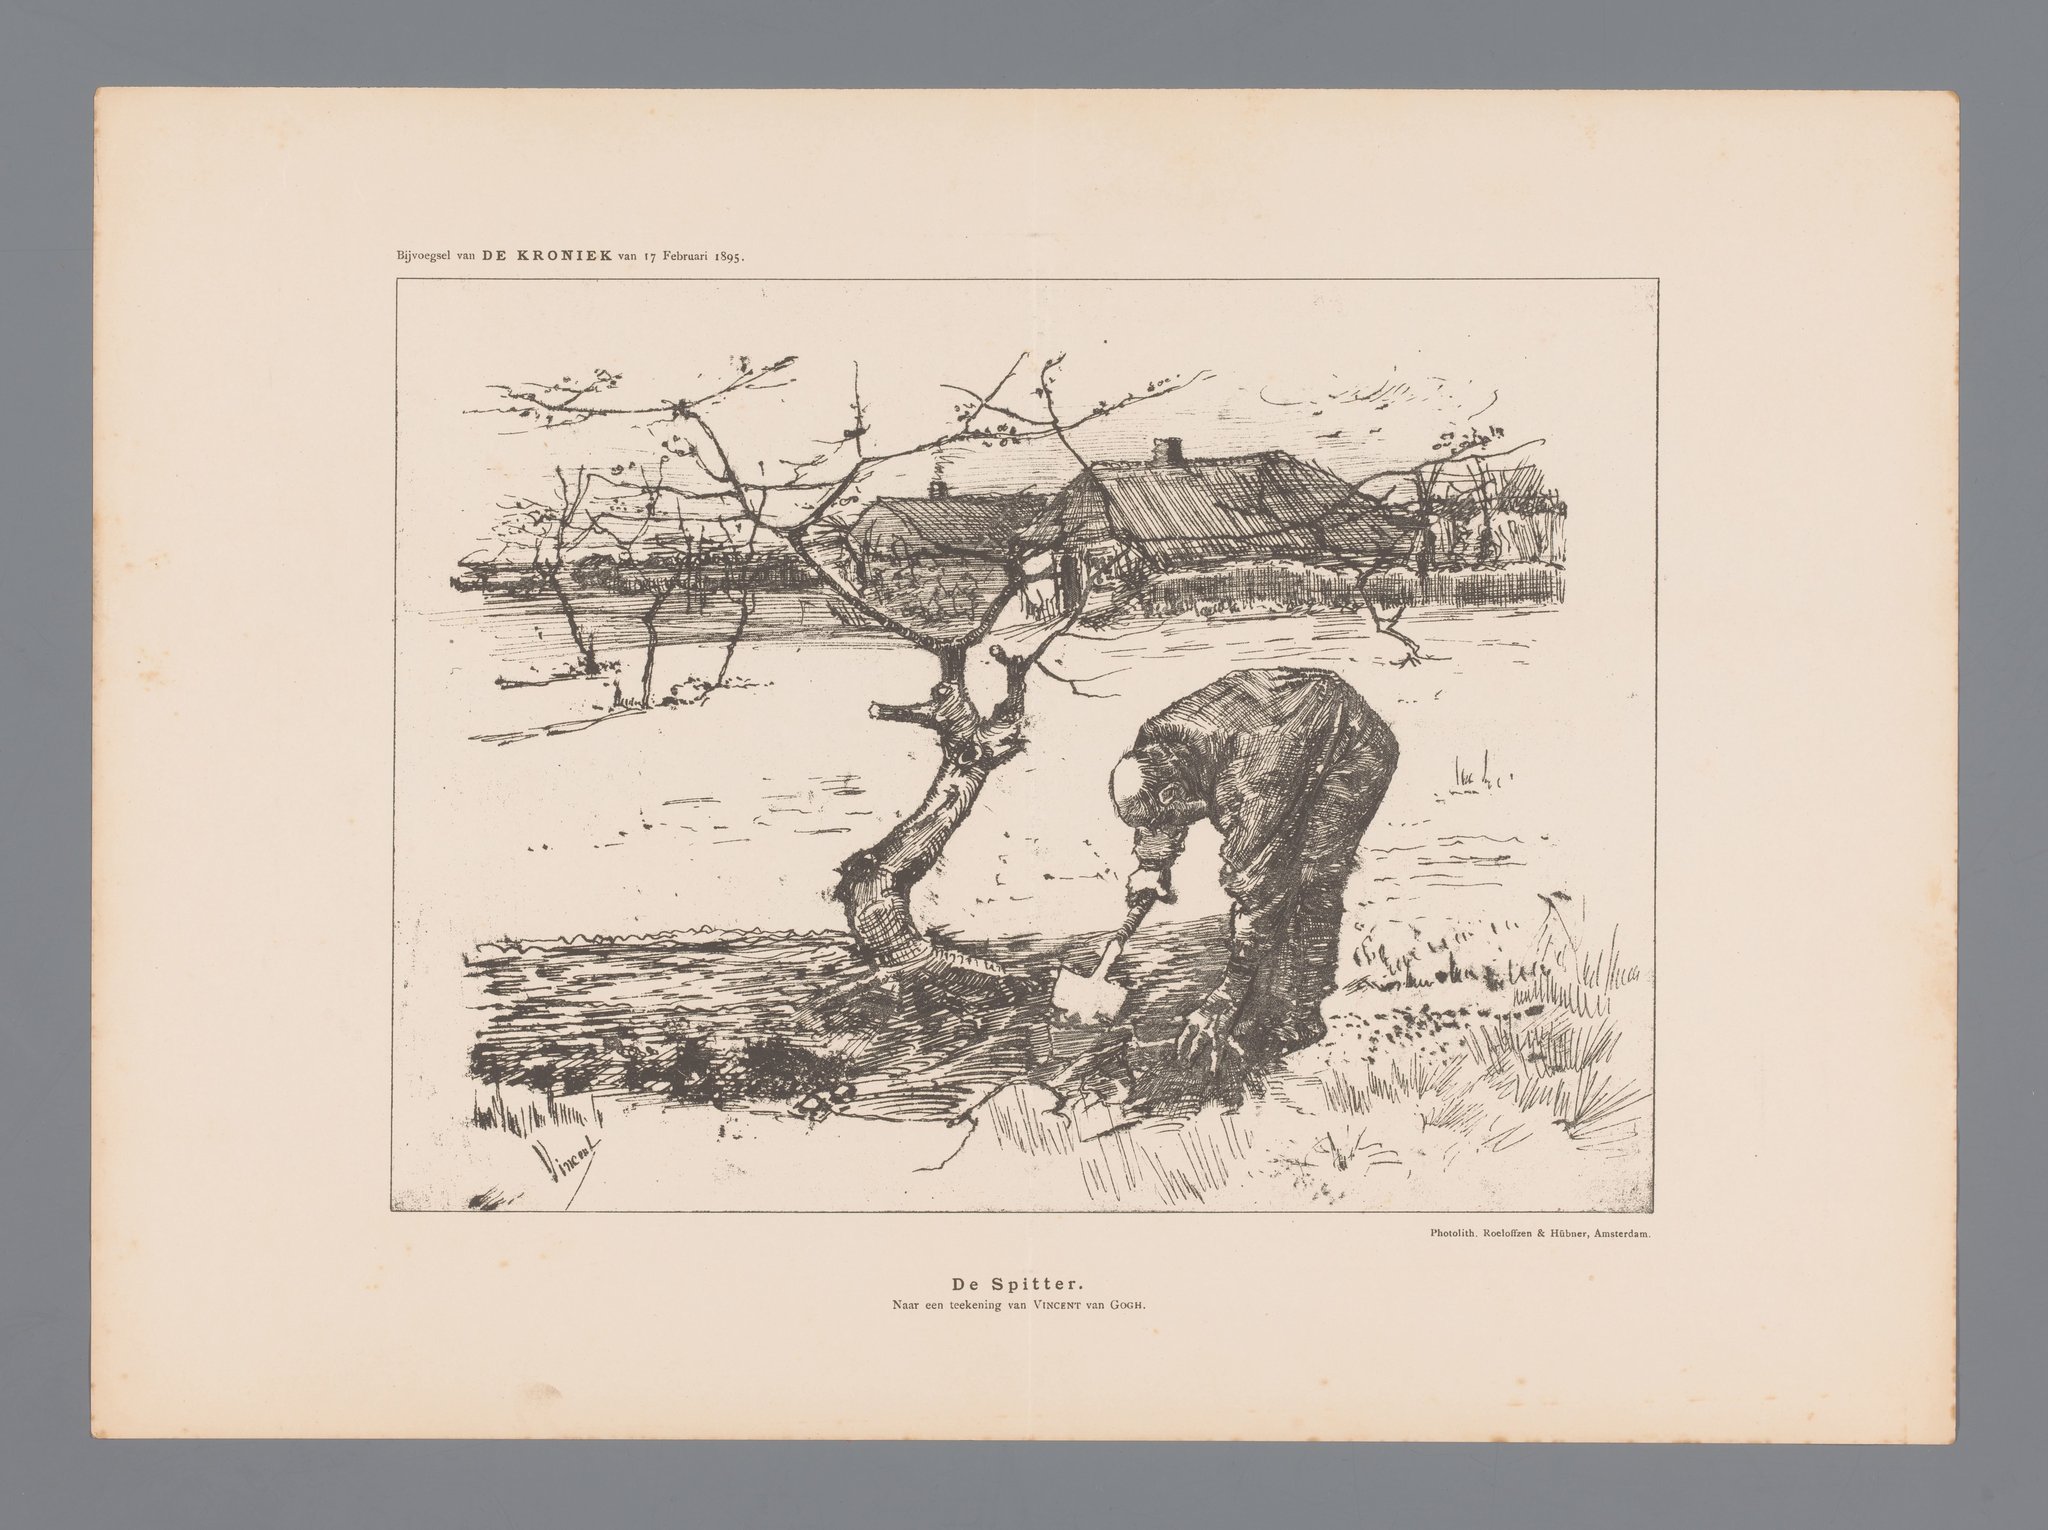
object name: photomechanical print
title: De Spitter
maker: vincent van gogh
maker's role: draughtsman, painter, print maker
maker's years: 1853-1890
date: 1895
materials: paper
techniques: photolithography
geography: amsterdam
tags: farmers, spading ~ soil cultivation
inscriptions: date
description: Prent uit het bijvoegsel van: De Kroniek 1 (1895), 17 februari 1895.